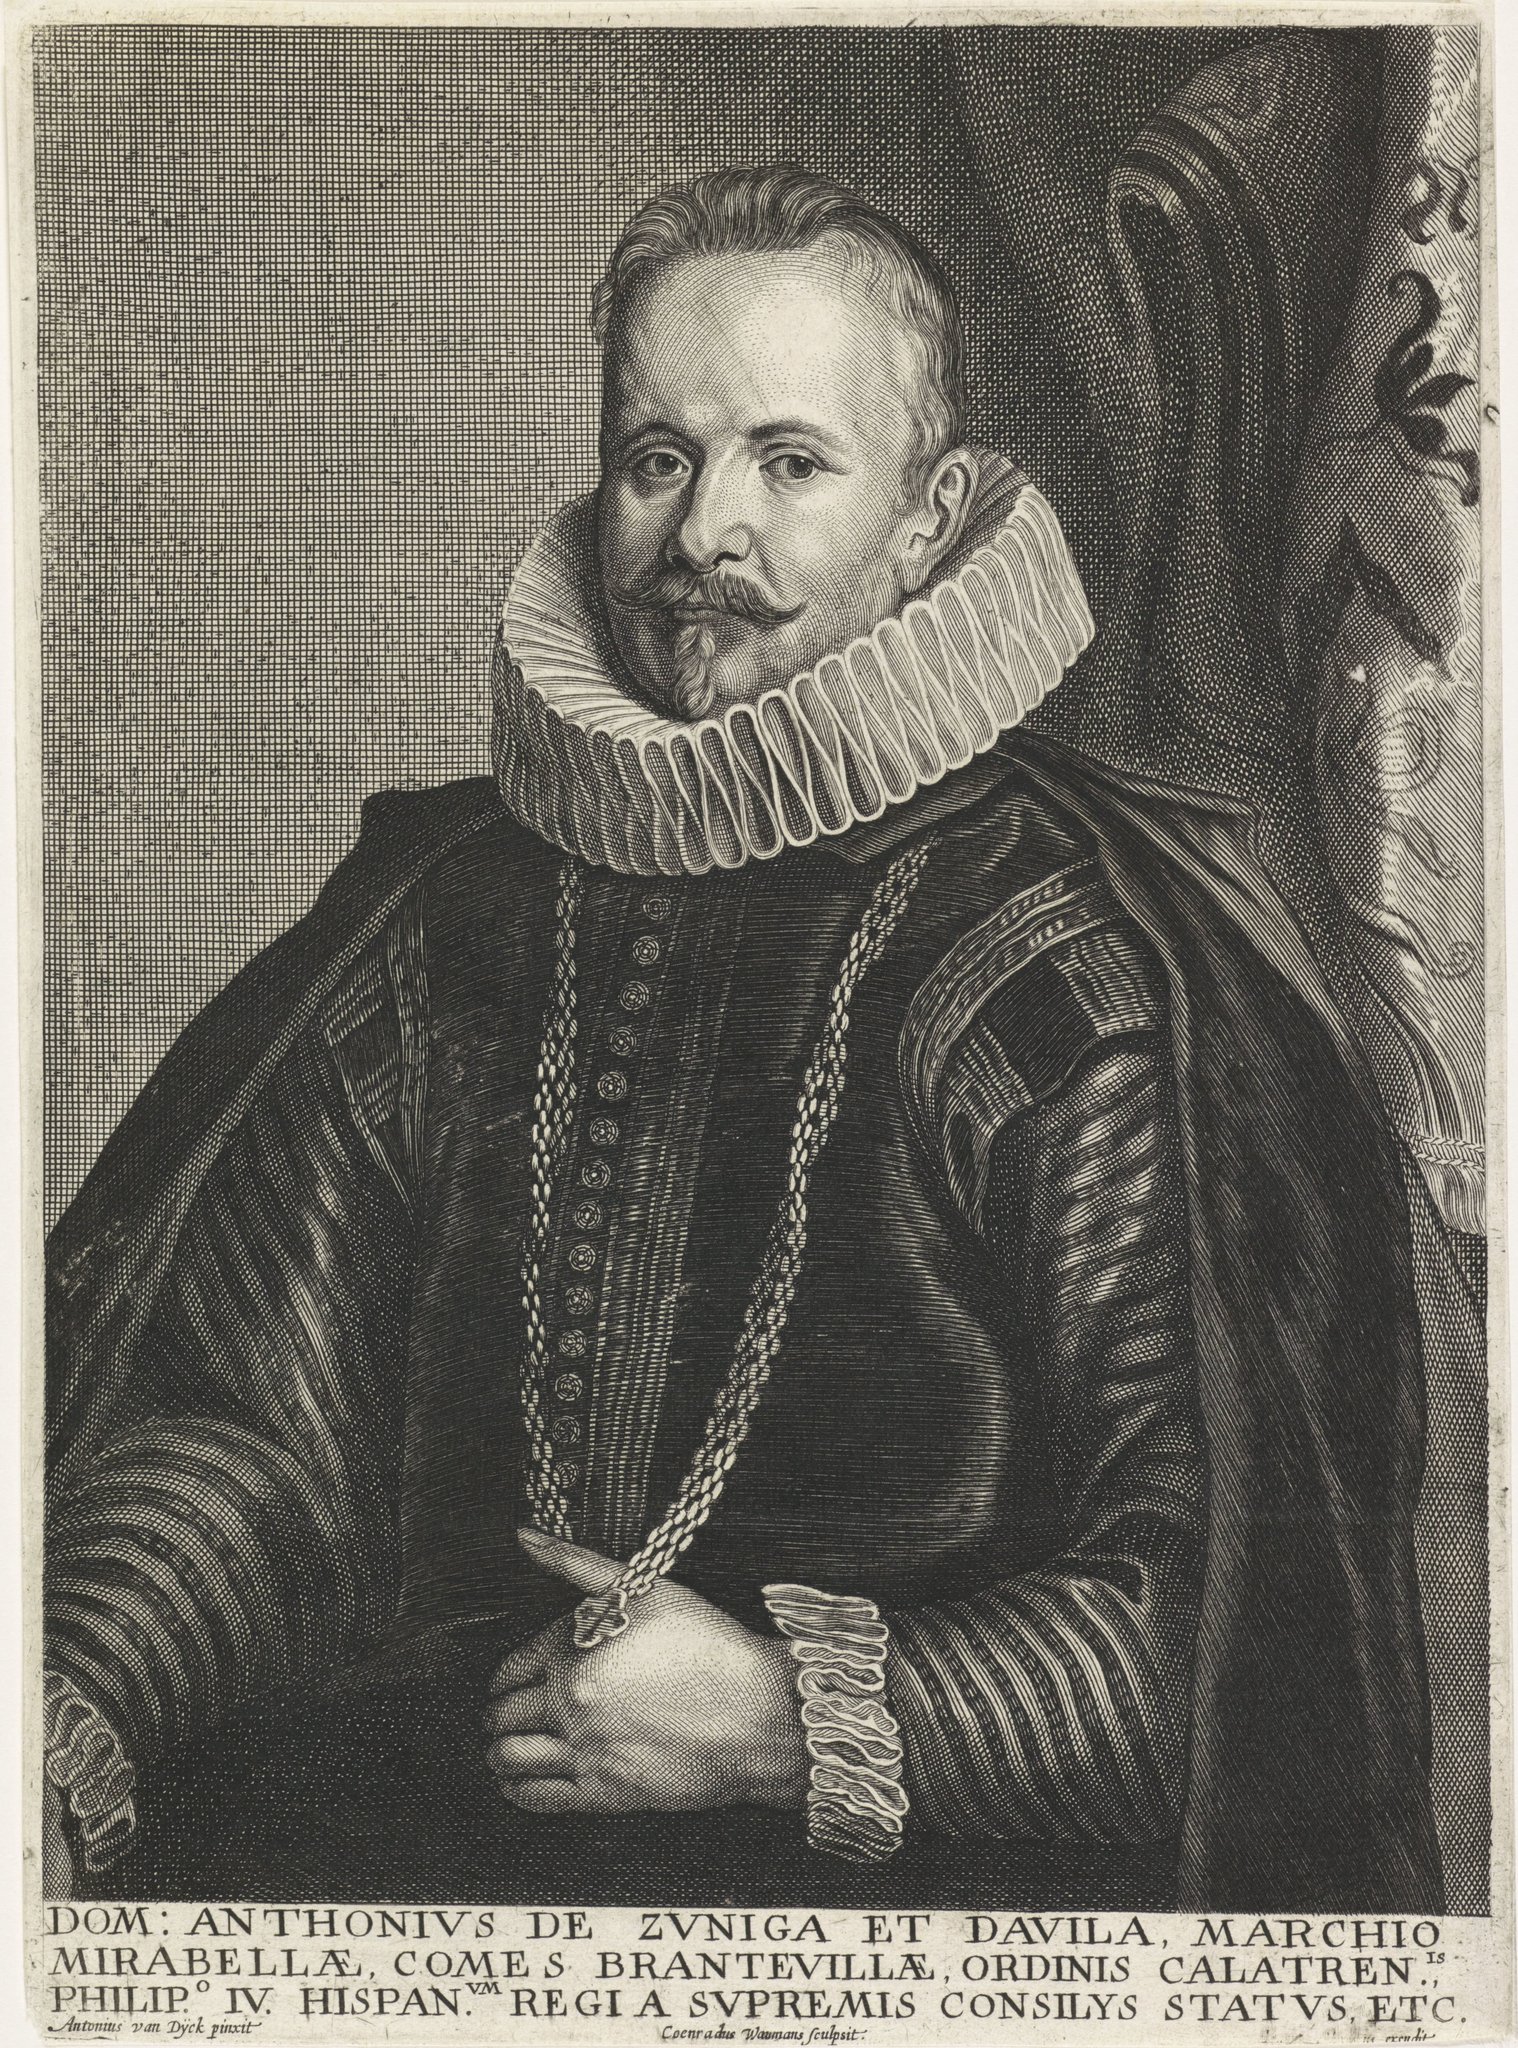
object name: print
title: Portret van Antonio Zúñiga y Dávila, markies van Mirabel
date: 1633-1673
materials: paper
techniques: engraving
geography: antwerp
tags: antonio zúñiga y dávila (markies van mirabel)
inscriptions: collector's mark: Lugt 2228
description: Portret van Antonio Zúñiga y Dávila, markies van Mirabel. In de marge een drieregelig onderschrift in het Latijn.